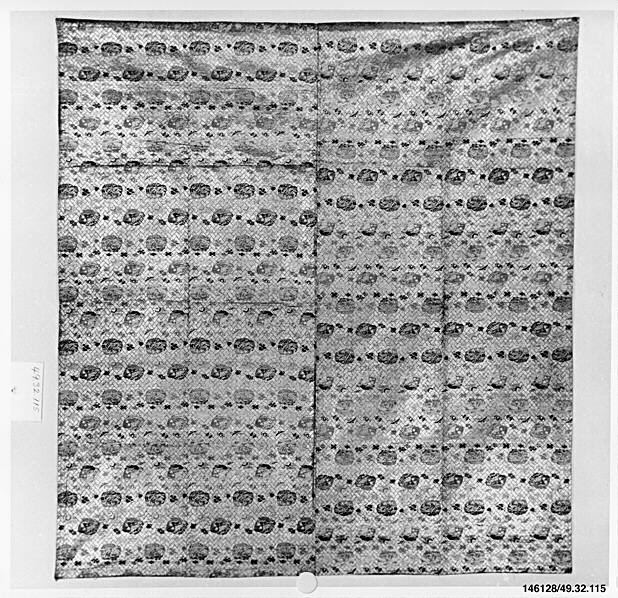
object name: altar cloth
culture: japanese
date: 1701-1800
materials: silk